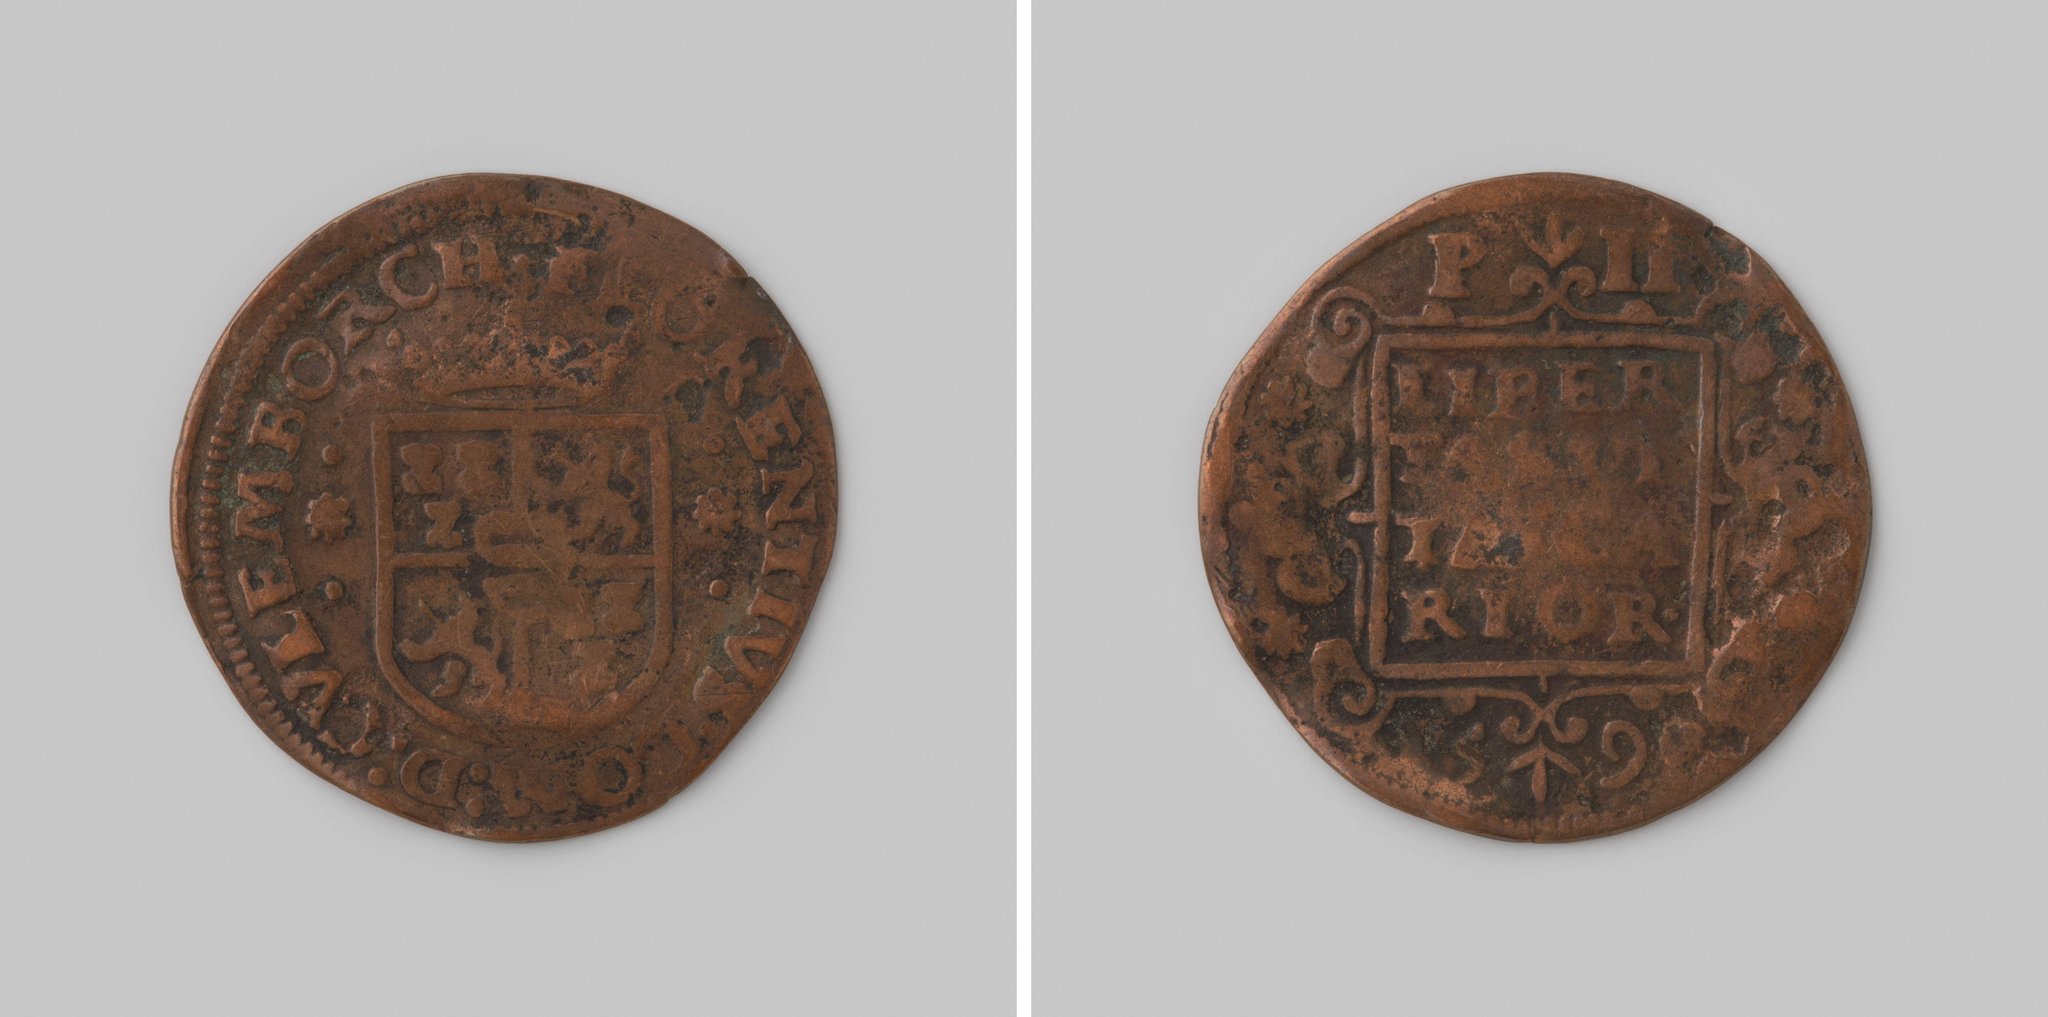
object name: coin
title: Culemborgse duit, 1590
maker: floris i van pallandt (graaf van culemborg)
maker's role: earl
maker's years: 1537-1598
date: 1590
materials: copper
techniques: striking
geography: culemborg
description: Voorzijde: gekroond wapenschild van de graaf van Culemborg. Keerzijde: binnen versierd vierkant opschrift in vier regels regels. Aan bovenkant van vierkant waarde-aanduiding P II [= 2 penningen].